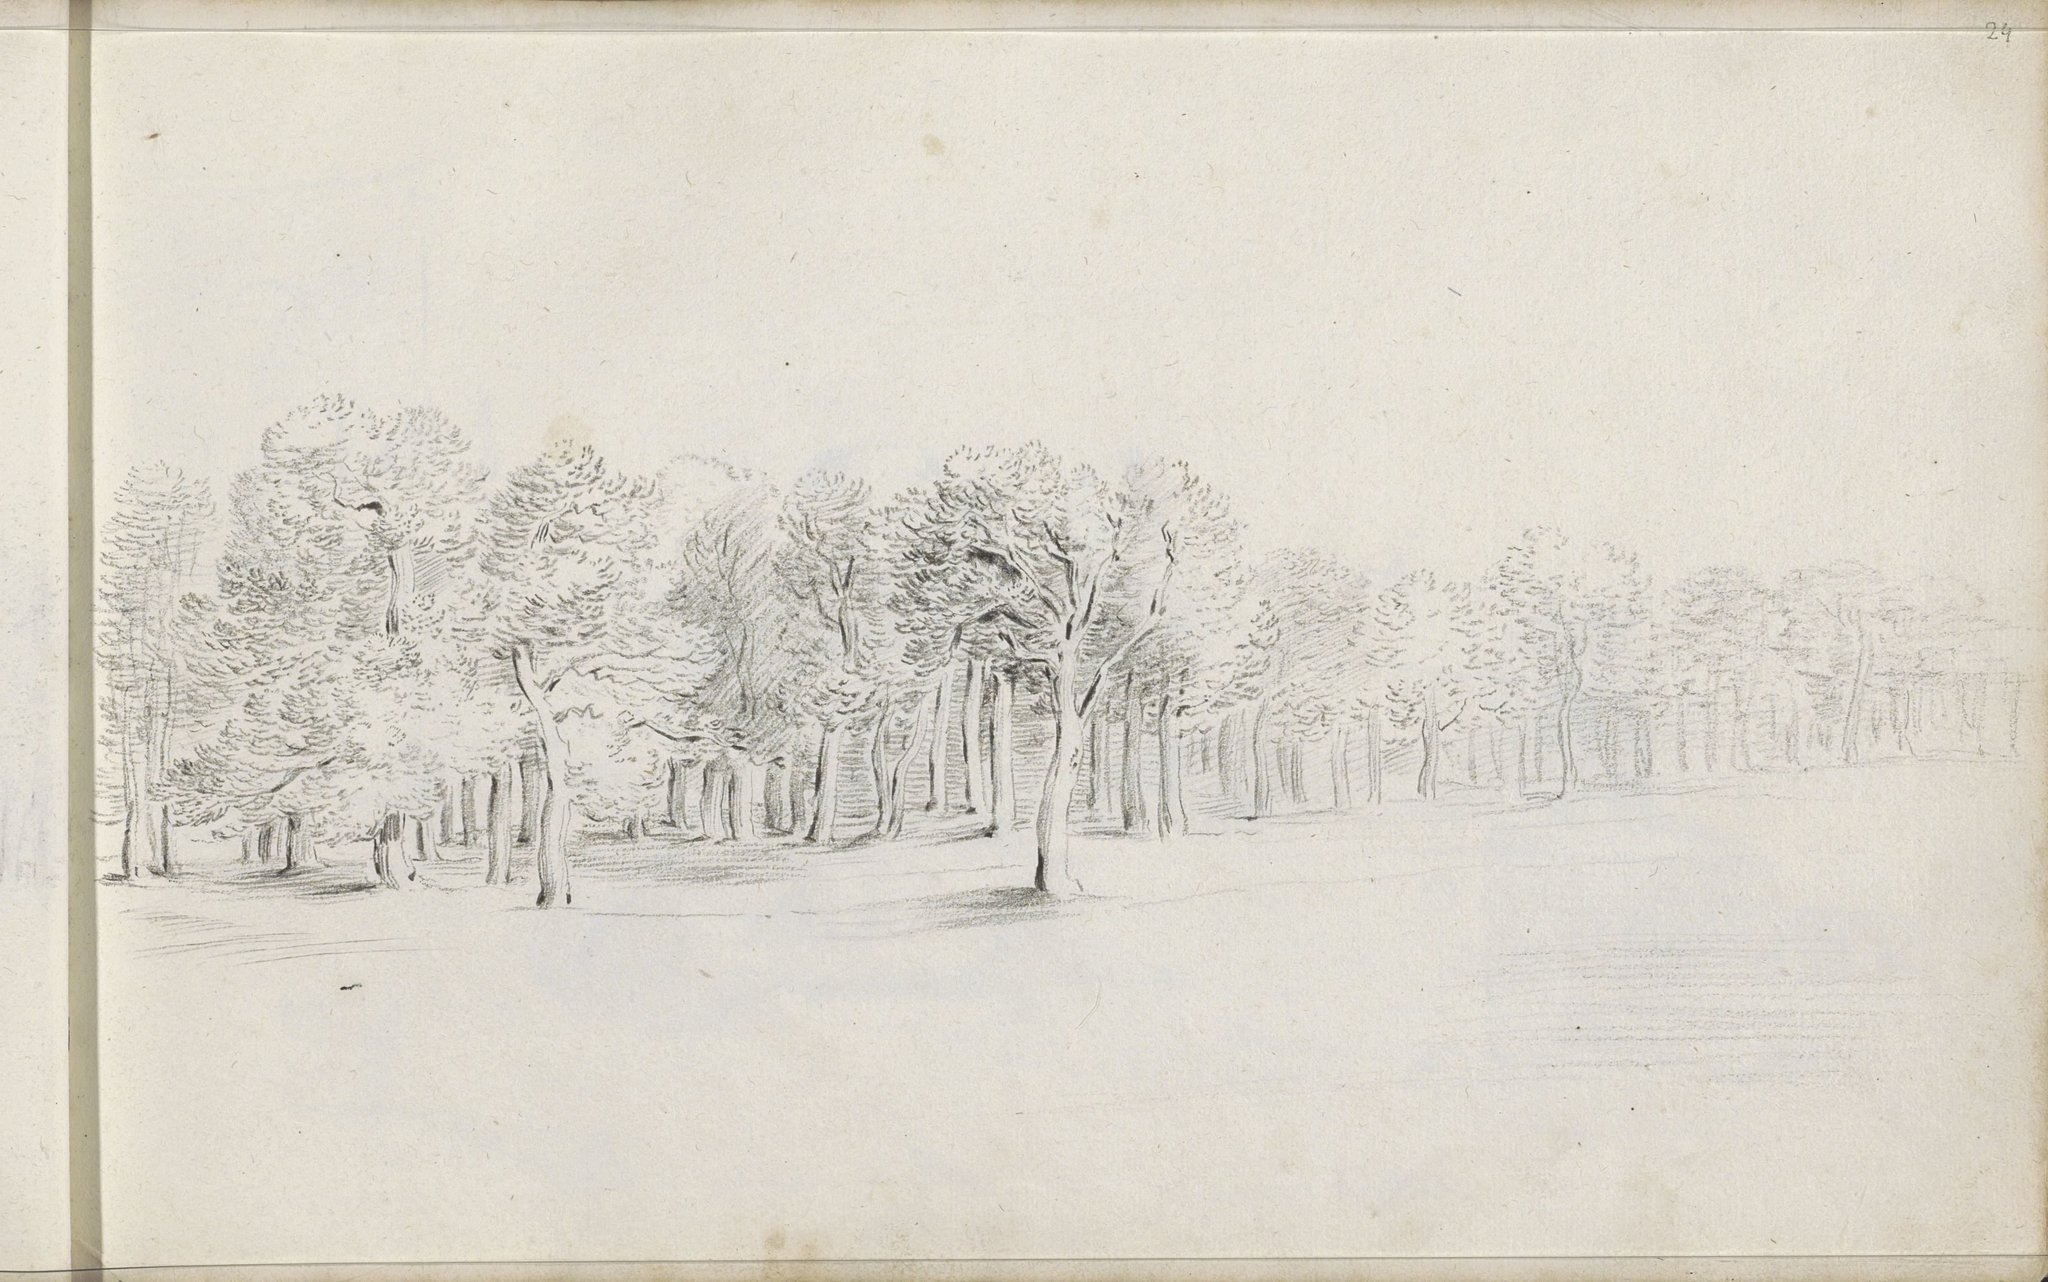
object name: sketchbook leaf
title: Bosrand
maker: pieter moninckx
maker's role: draughtsman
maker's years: 1606-1686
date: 1645-1646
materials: chalk, paper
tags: fringe, edge of the wood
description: Blad 24 recto uit een schetsboek met 39 bladen.